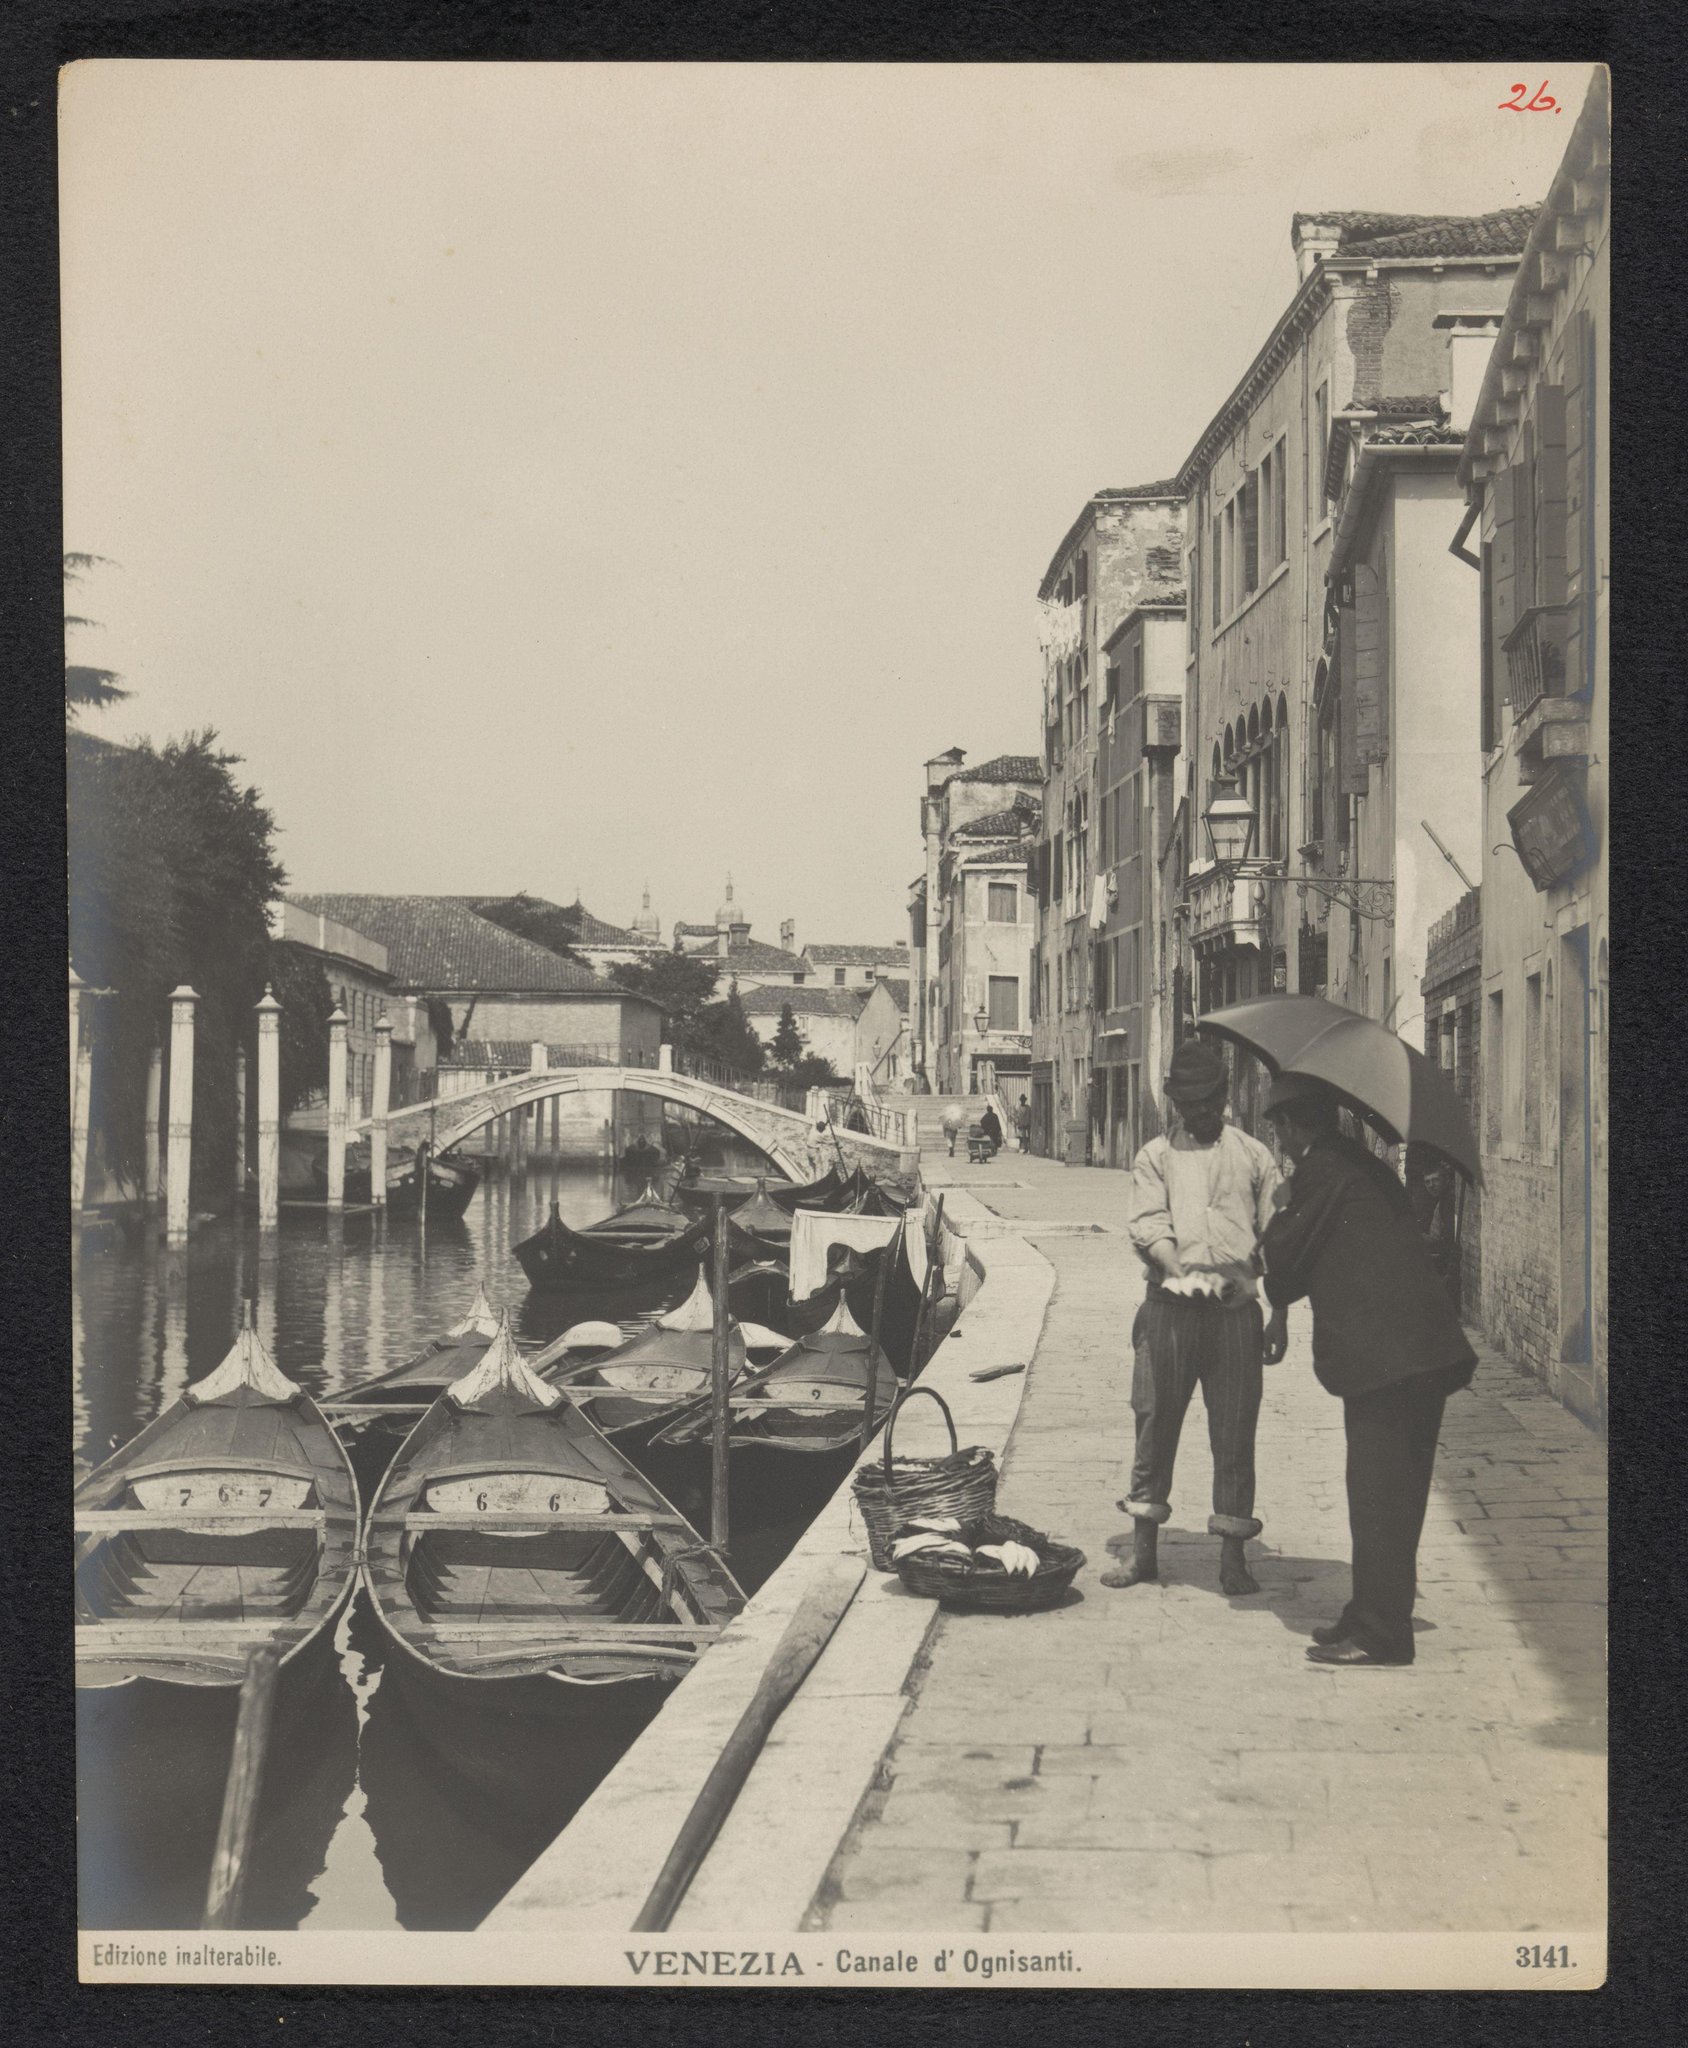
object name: photograph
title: Gondels op het Canale di Ognissanti te Venetië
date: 1900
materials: cardboard, photographic support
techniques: gelatin silver print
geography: venice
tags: canal, façade (of house or building), gondola, venice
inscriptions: number: ‘26.’, inscription: ‘Rijksnormaalschool voor Teekenonderwijzers Amsterdam’, number: ‘3141.’